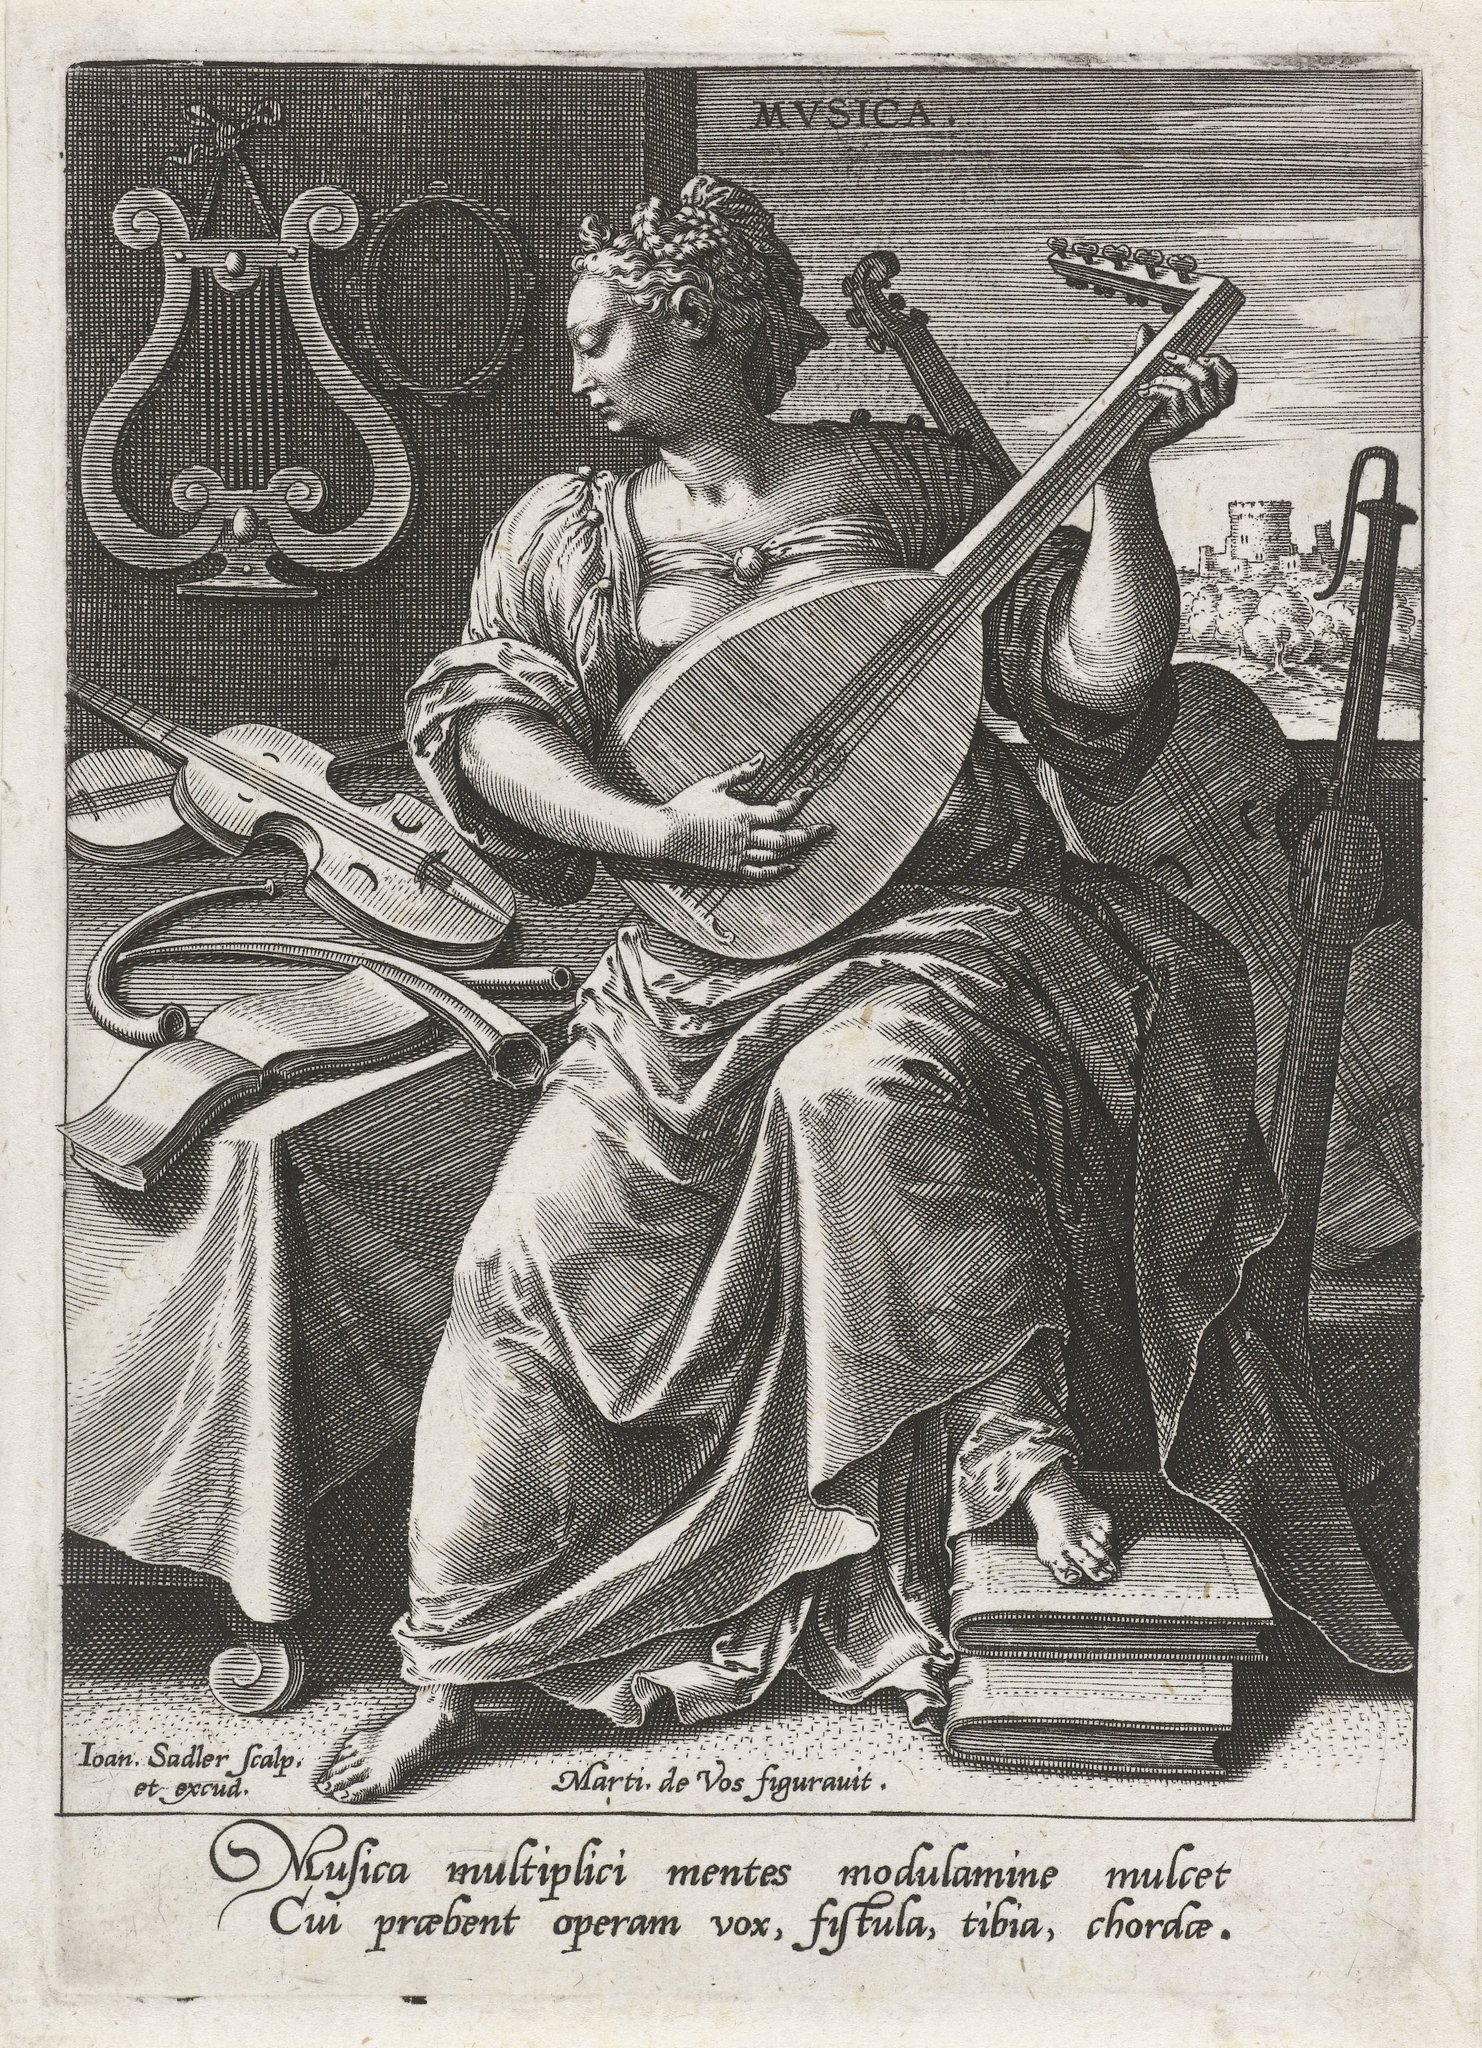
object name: print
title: Musica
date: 1560-1600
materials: paper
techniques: engraving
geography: antwerp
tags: musical instruments; group of musical instruments, horn, trumpet, cornet, trombone, tuba, 'musica' (~ quadrivium); 'musica' (ripa), violin, fiddle, harp, clarinet, bassoon, oboe, shawm, lute, and special forms of lute, e.g.: theorbo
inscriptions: collector's mark: Lugt 240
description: De personificatie van Muziek, de luit spelend. Ze zit aan een tafel met andere muziekinstrumenten zoals hoorn, viool, lier en schalmei. De prent heeft een Latijns onderschrift over de muziek en maakt deel uit van een zevendelige serie over de zeven vrije kunsten.